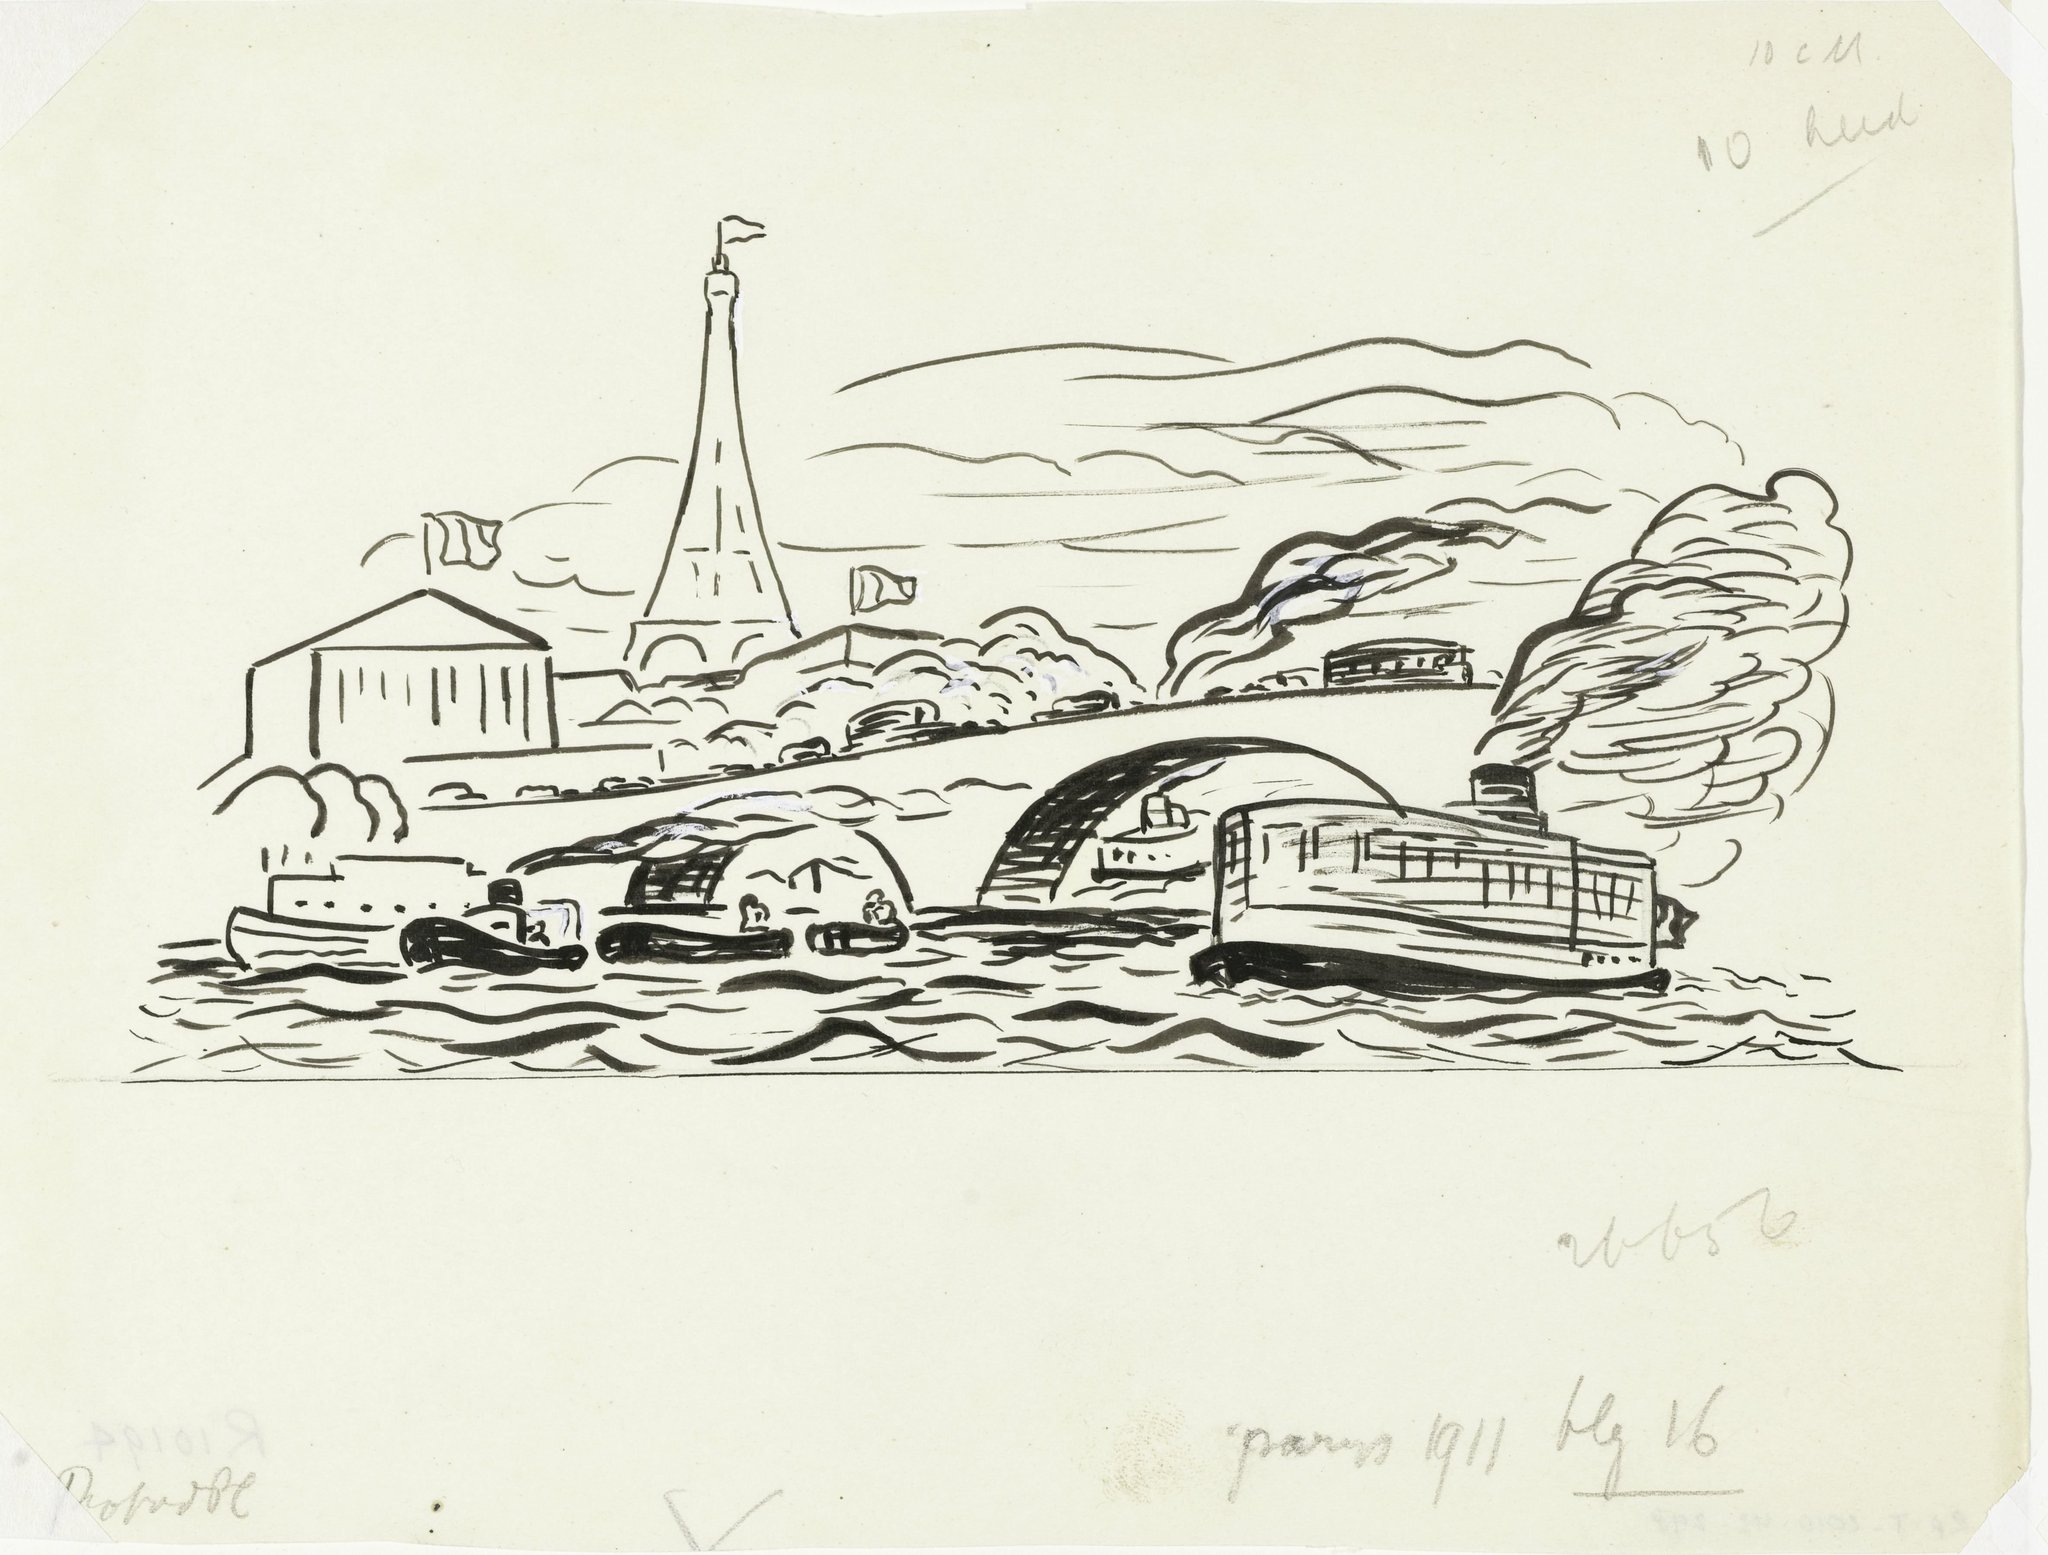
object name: drawing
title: Vignet voor biografie van Gestel door Prof. W. van der Pluym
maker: leo gestel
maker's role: draughtsman, print maker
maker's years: 1881-1941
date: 1935-1936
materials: paint, ink, paper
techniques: brush, pen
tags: print maker, draughtsman, leo gestel, city-view in general; 'veduta', paris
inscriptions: inscription: ‘10 c M / 10 breed’, number: ‘26656’, inscription: ‘parijs 1911 blz 16’, inscription: ‘ProfvdPl’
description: Gezicht op Parijs, met boten op Seine en Eiffeltoren op de achtergrond